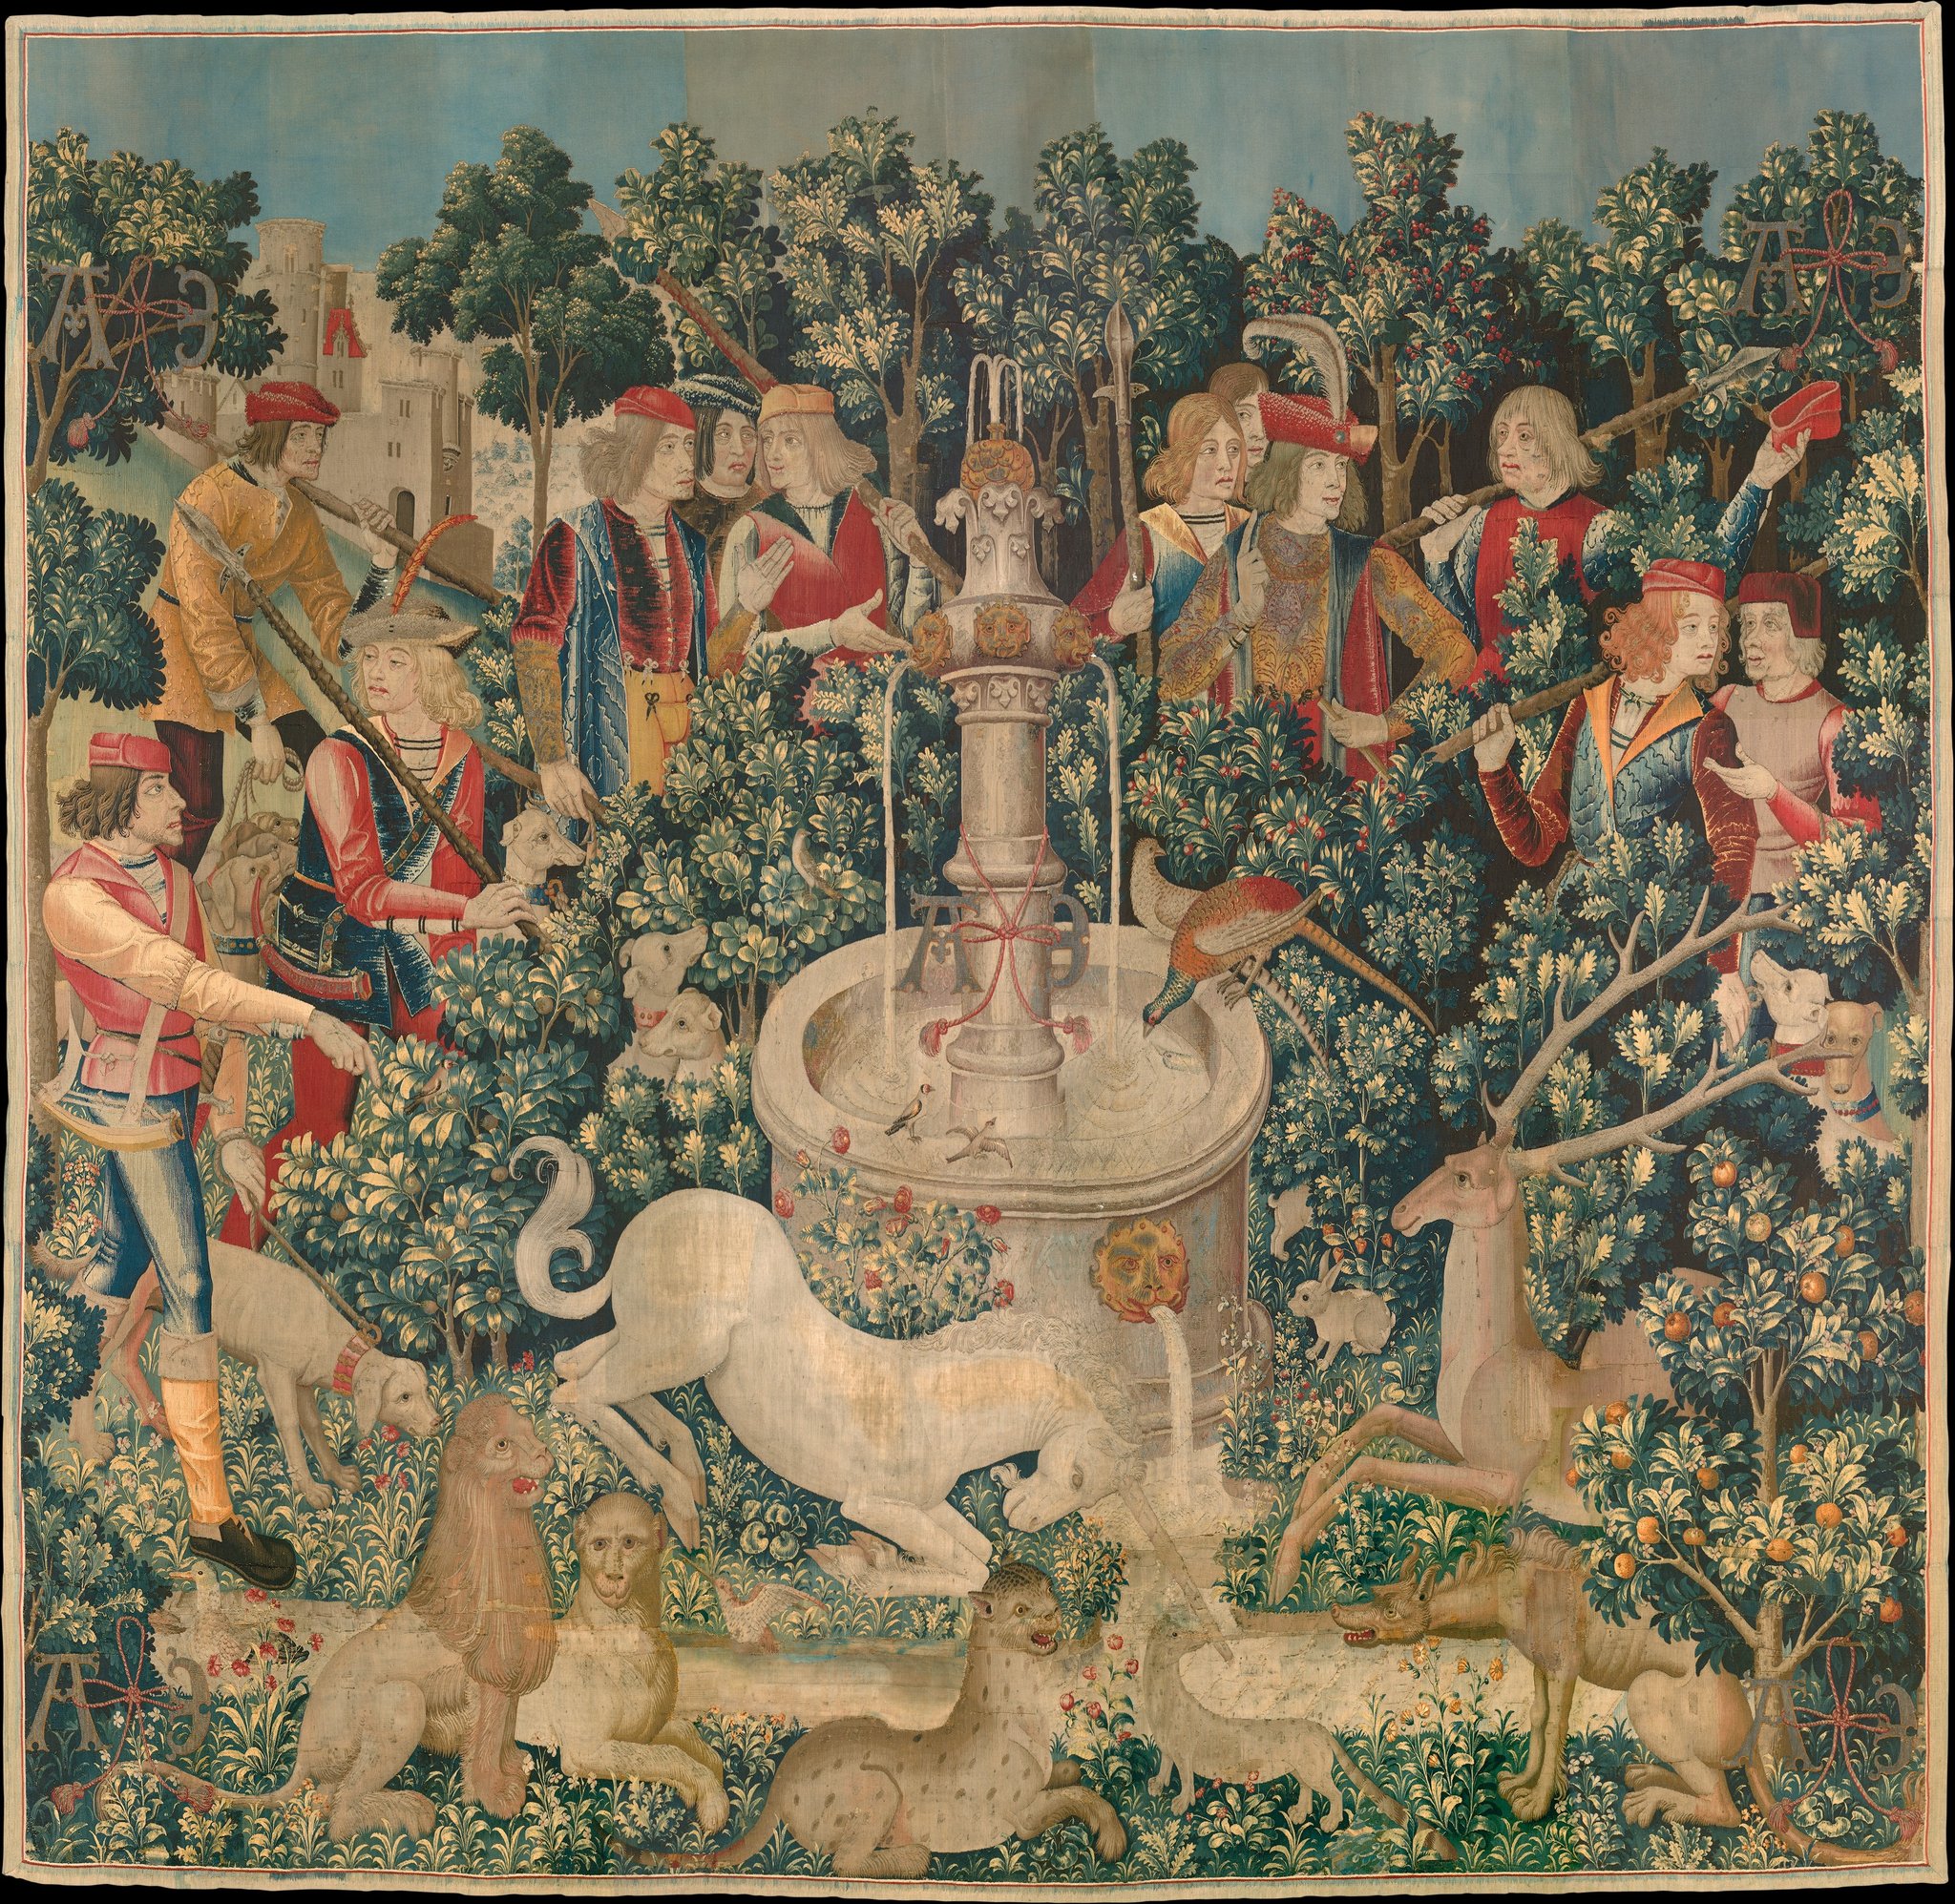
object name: tapestry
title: The Unicorn Purifies Water (from the Unicorn Tapestries)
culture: french or south netherlandish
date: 1495-1505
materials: gilt, silk, silver, wool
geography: netherlands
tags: birds,fountains,men,unicorns,pheasants,deer,dogs,lions,rabbits